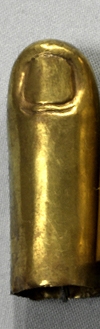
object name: finger stall, group 2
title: Finger stall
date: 1479-1425 BCE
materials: gold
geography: egypt